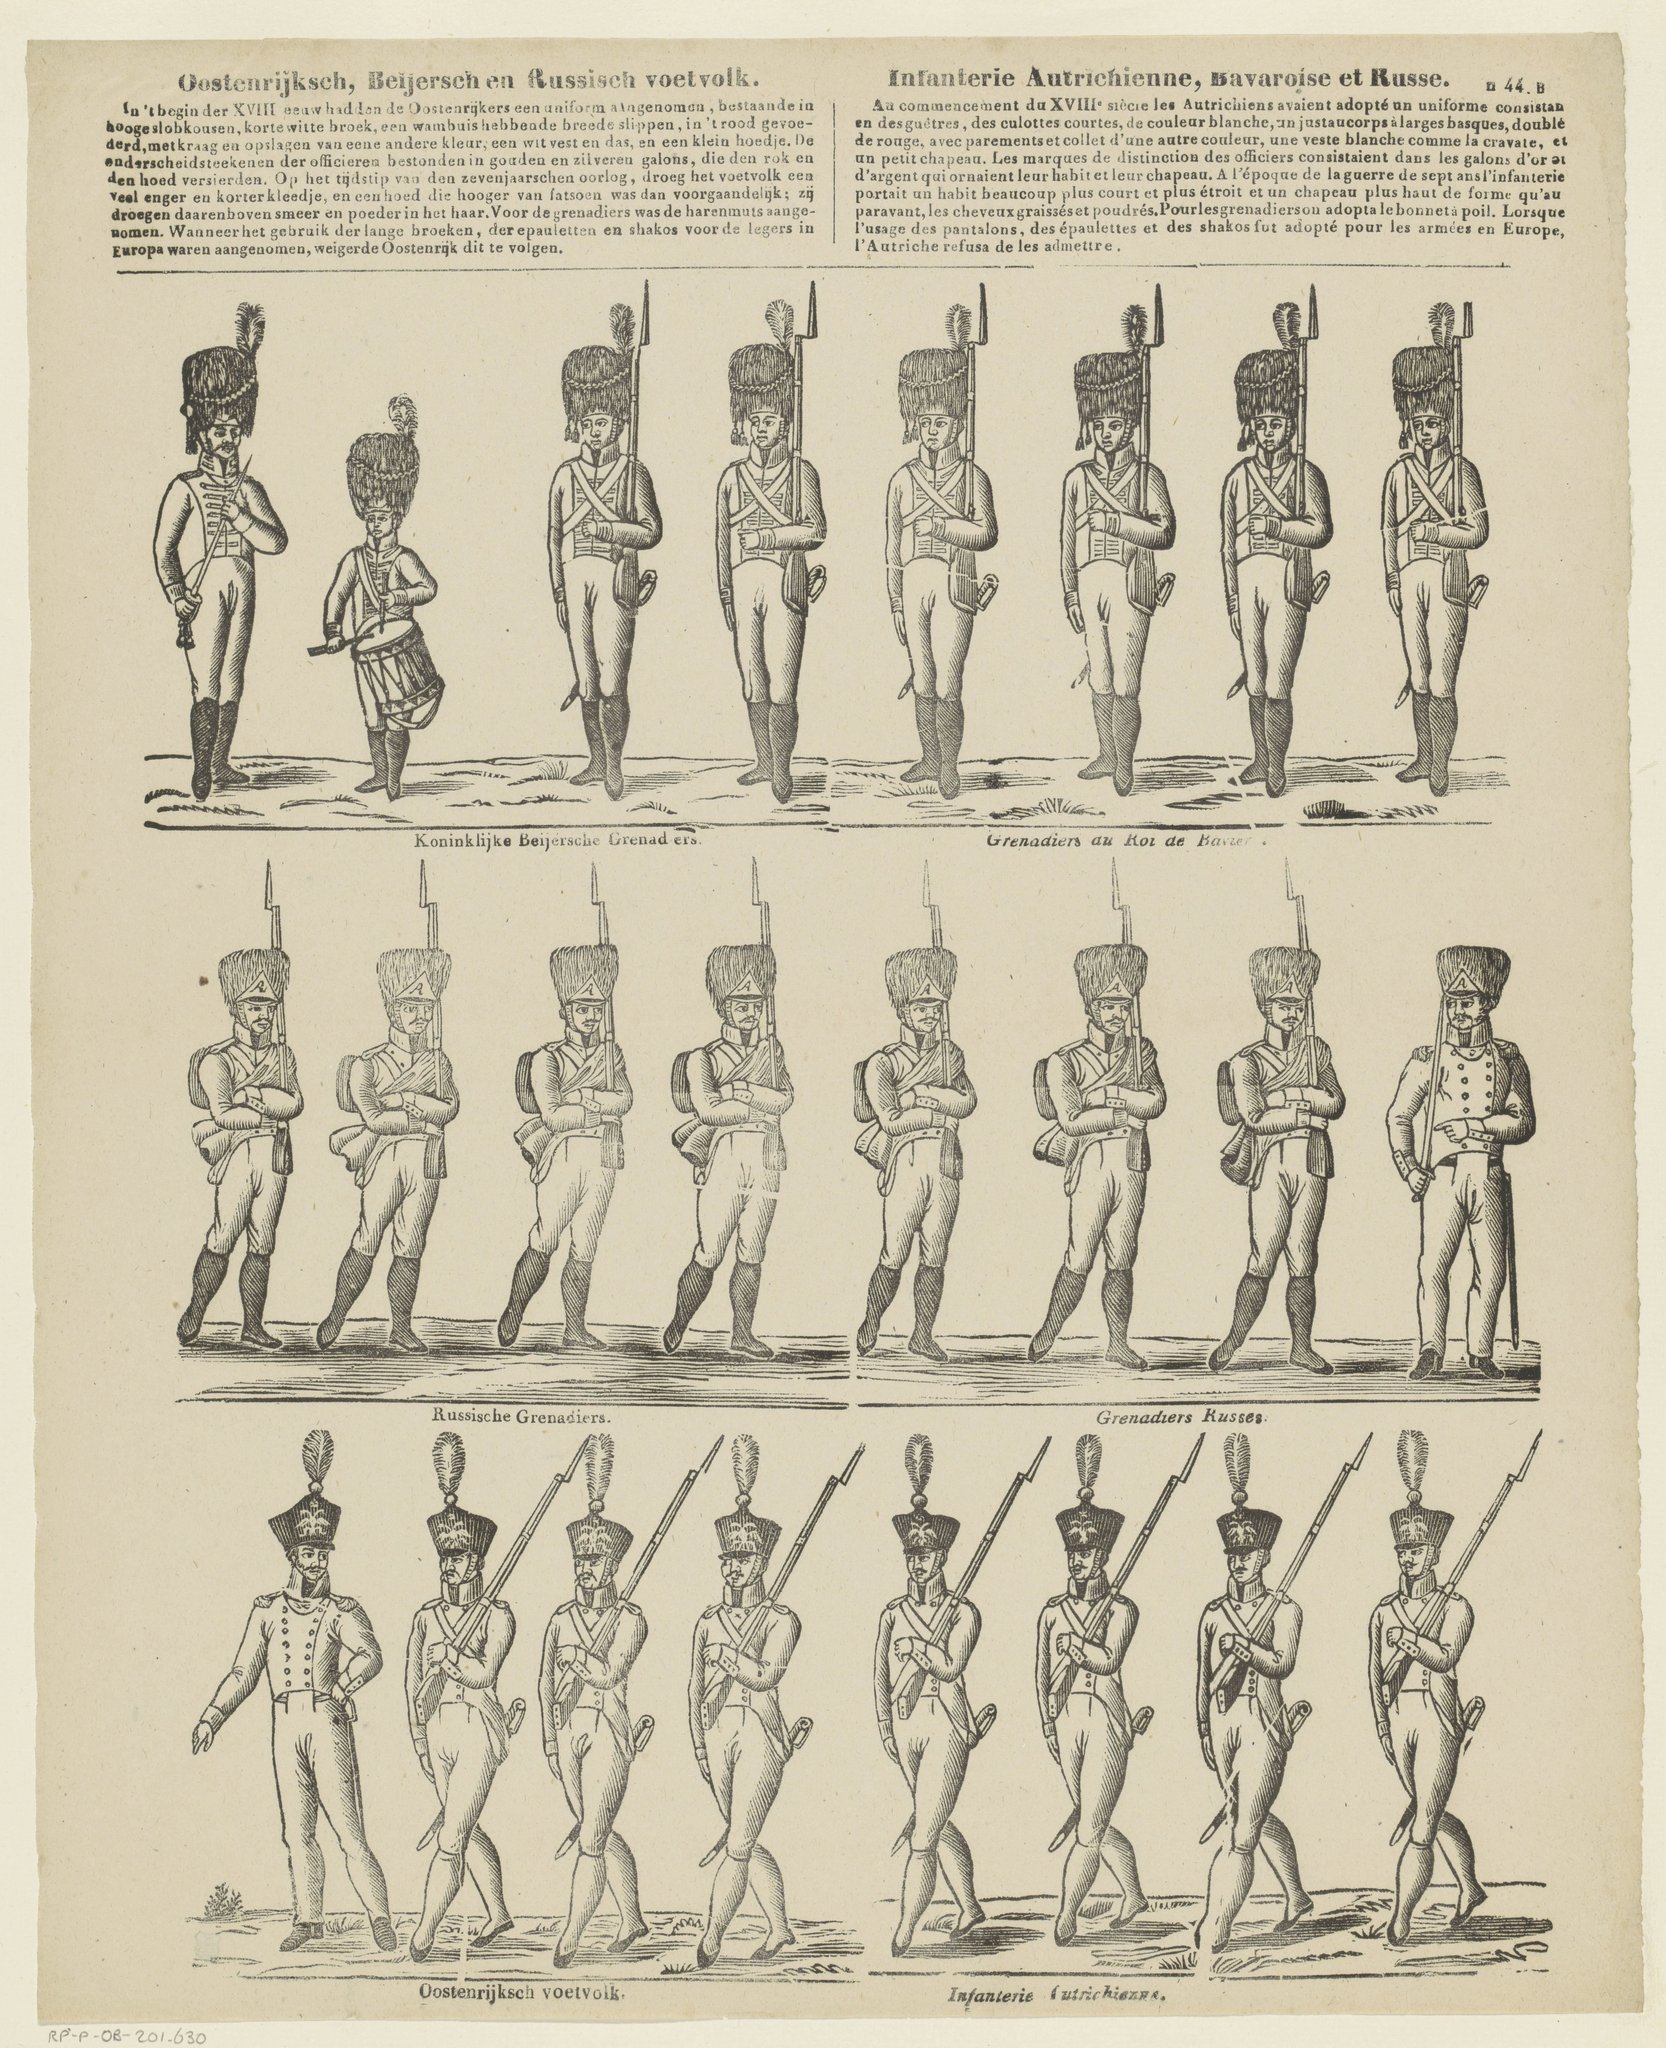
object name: print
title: Oostenrijksch, Beijersch en Russisch voetvolk / Infanterie Autrichienne, Bavaroise et Russe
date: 1800-1833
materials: paper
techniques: letterpress printing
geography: turnhout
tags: the soldier; the soldier's life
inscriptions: collector's mark: Lugt 2760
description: Blad met 3 horizontale rijen met elk acht militairen op een rij. Op de bovenste rij Beierse soldaten, op de middelste rij Russische soldaten en op de onderste rij Oorstenrijkse soldaten. Onder elke voorstelling een onderschrift in het Nederlands en in het Frans. Een achtienregelig bovenschrift bovenschrift in twee kolommen in het Nederlands en in het Frans. Genummerd rechtsboven: n 44. B.